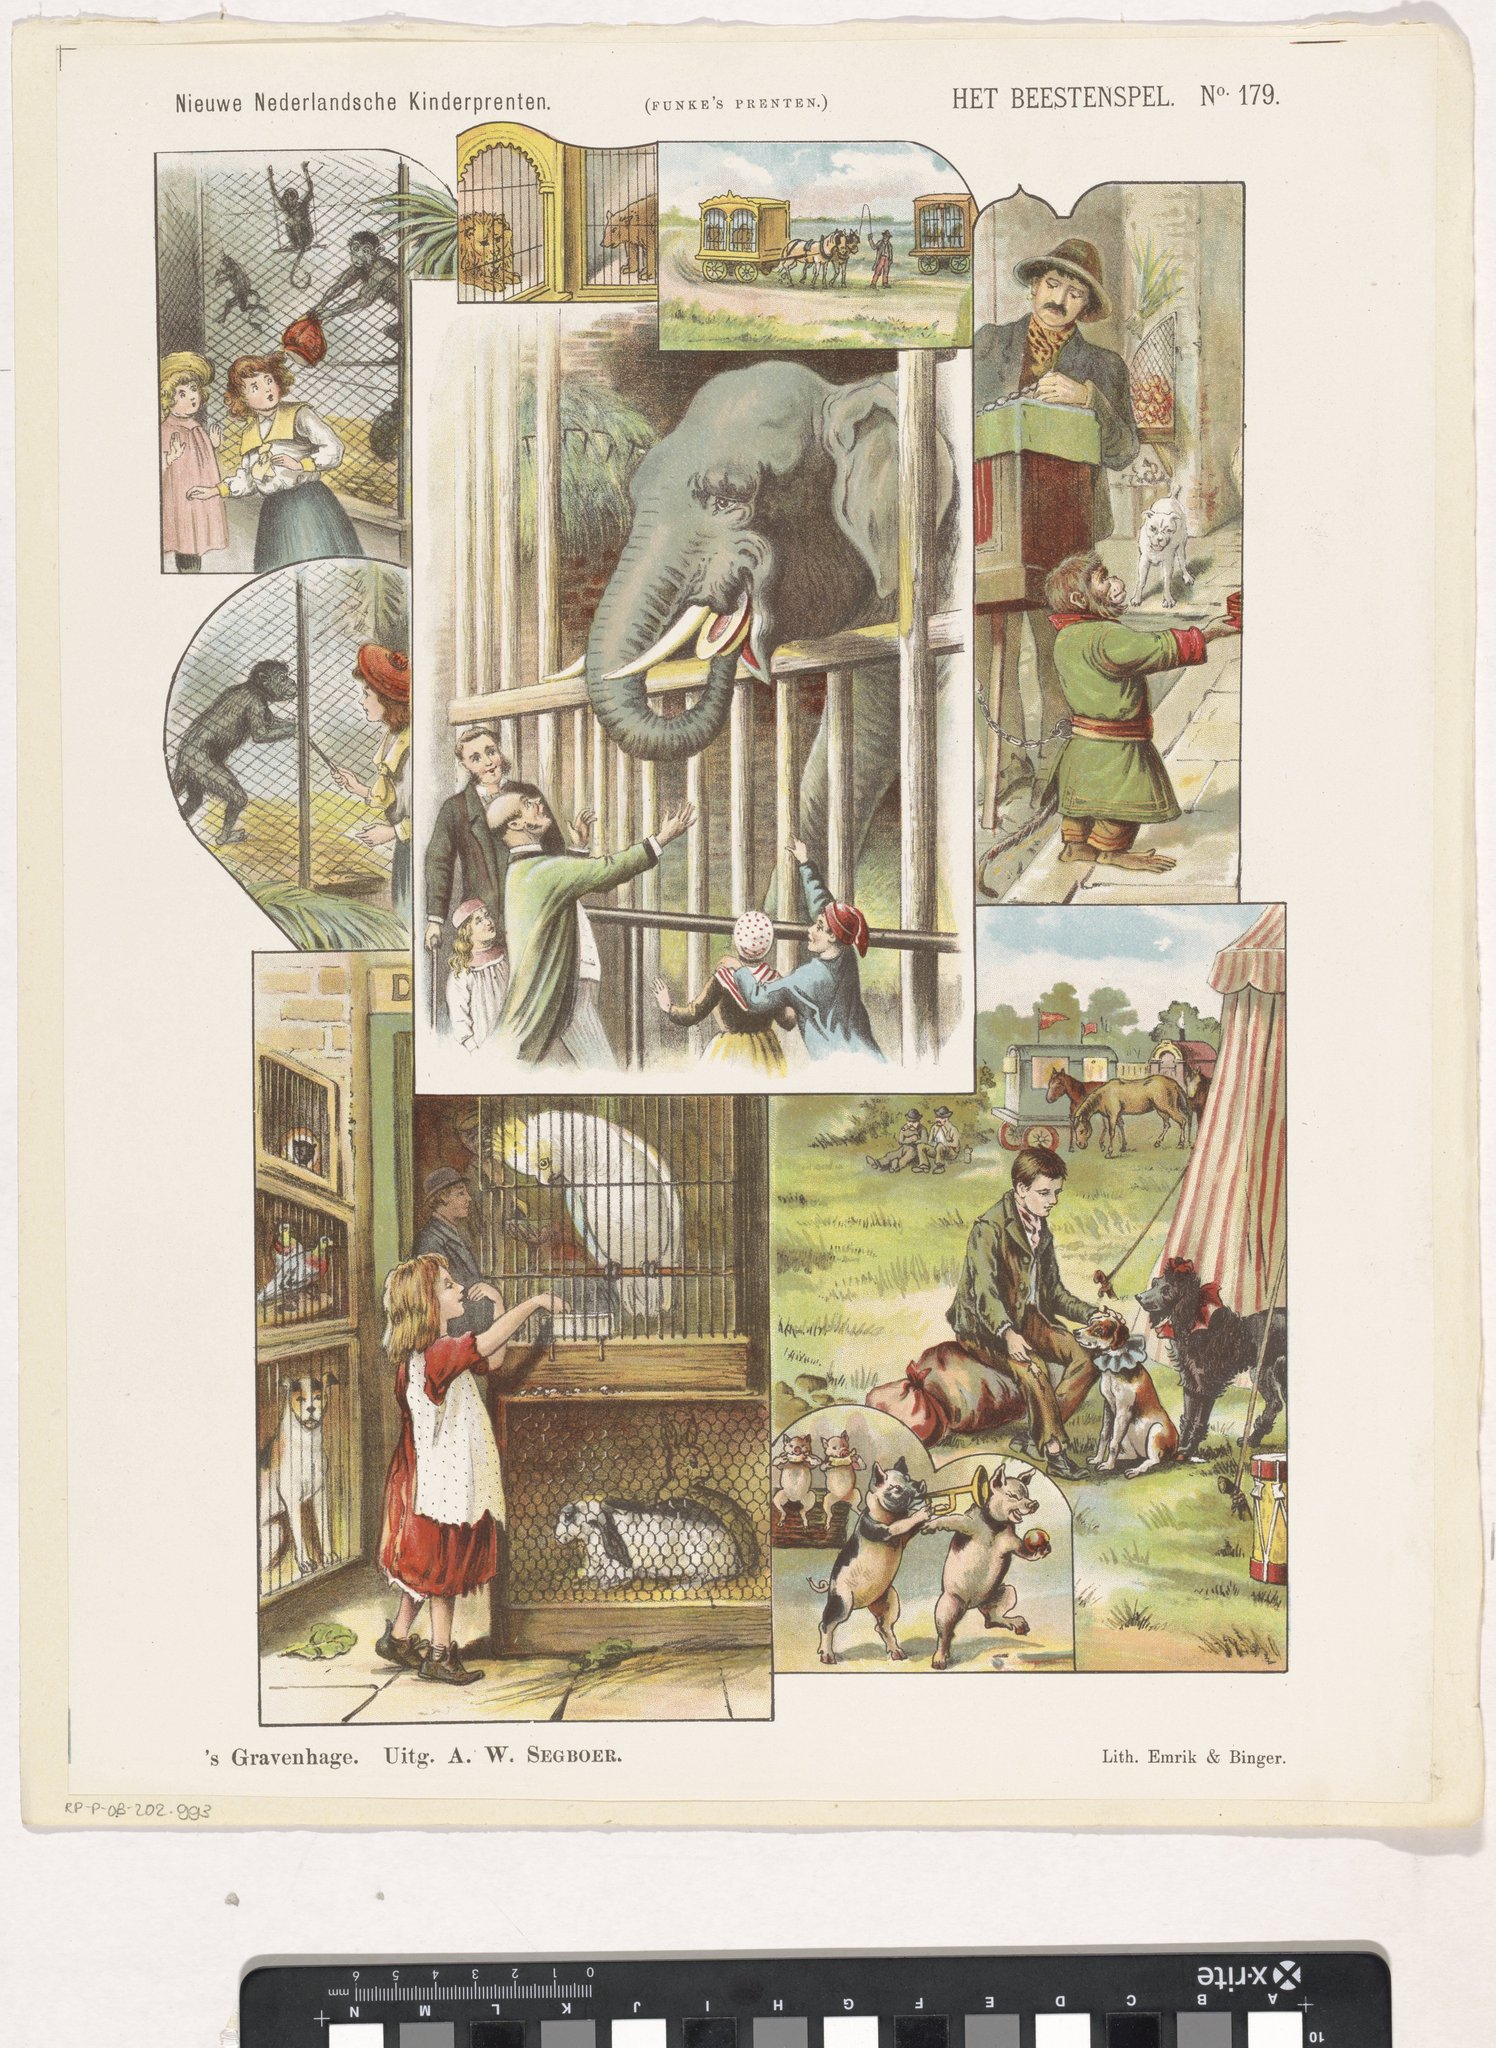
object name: popular print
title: Nieuwe Nederlandsche kinderprenten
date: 1903-1919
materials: paper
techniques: lithograph, letterpress printing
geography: haarlem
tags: circus animals, monkeys, apes, dogs (circus performance), trunked animals: elephant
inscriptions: collector's mark: Lugt 2760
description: Blad met 8 voorstellingen van circusdieren, waaronder apen en een olifant. Genummerd rechtsboven: No. 179.